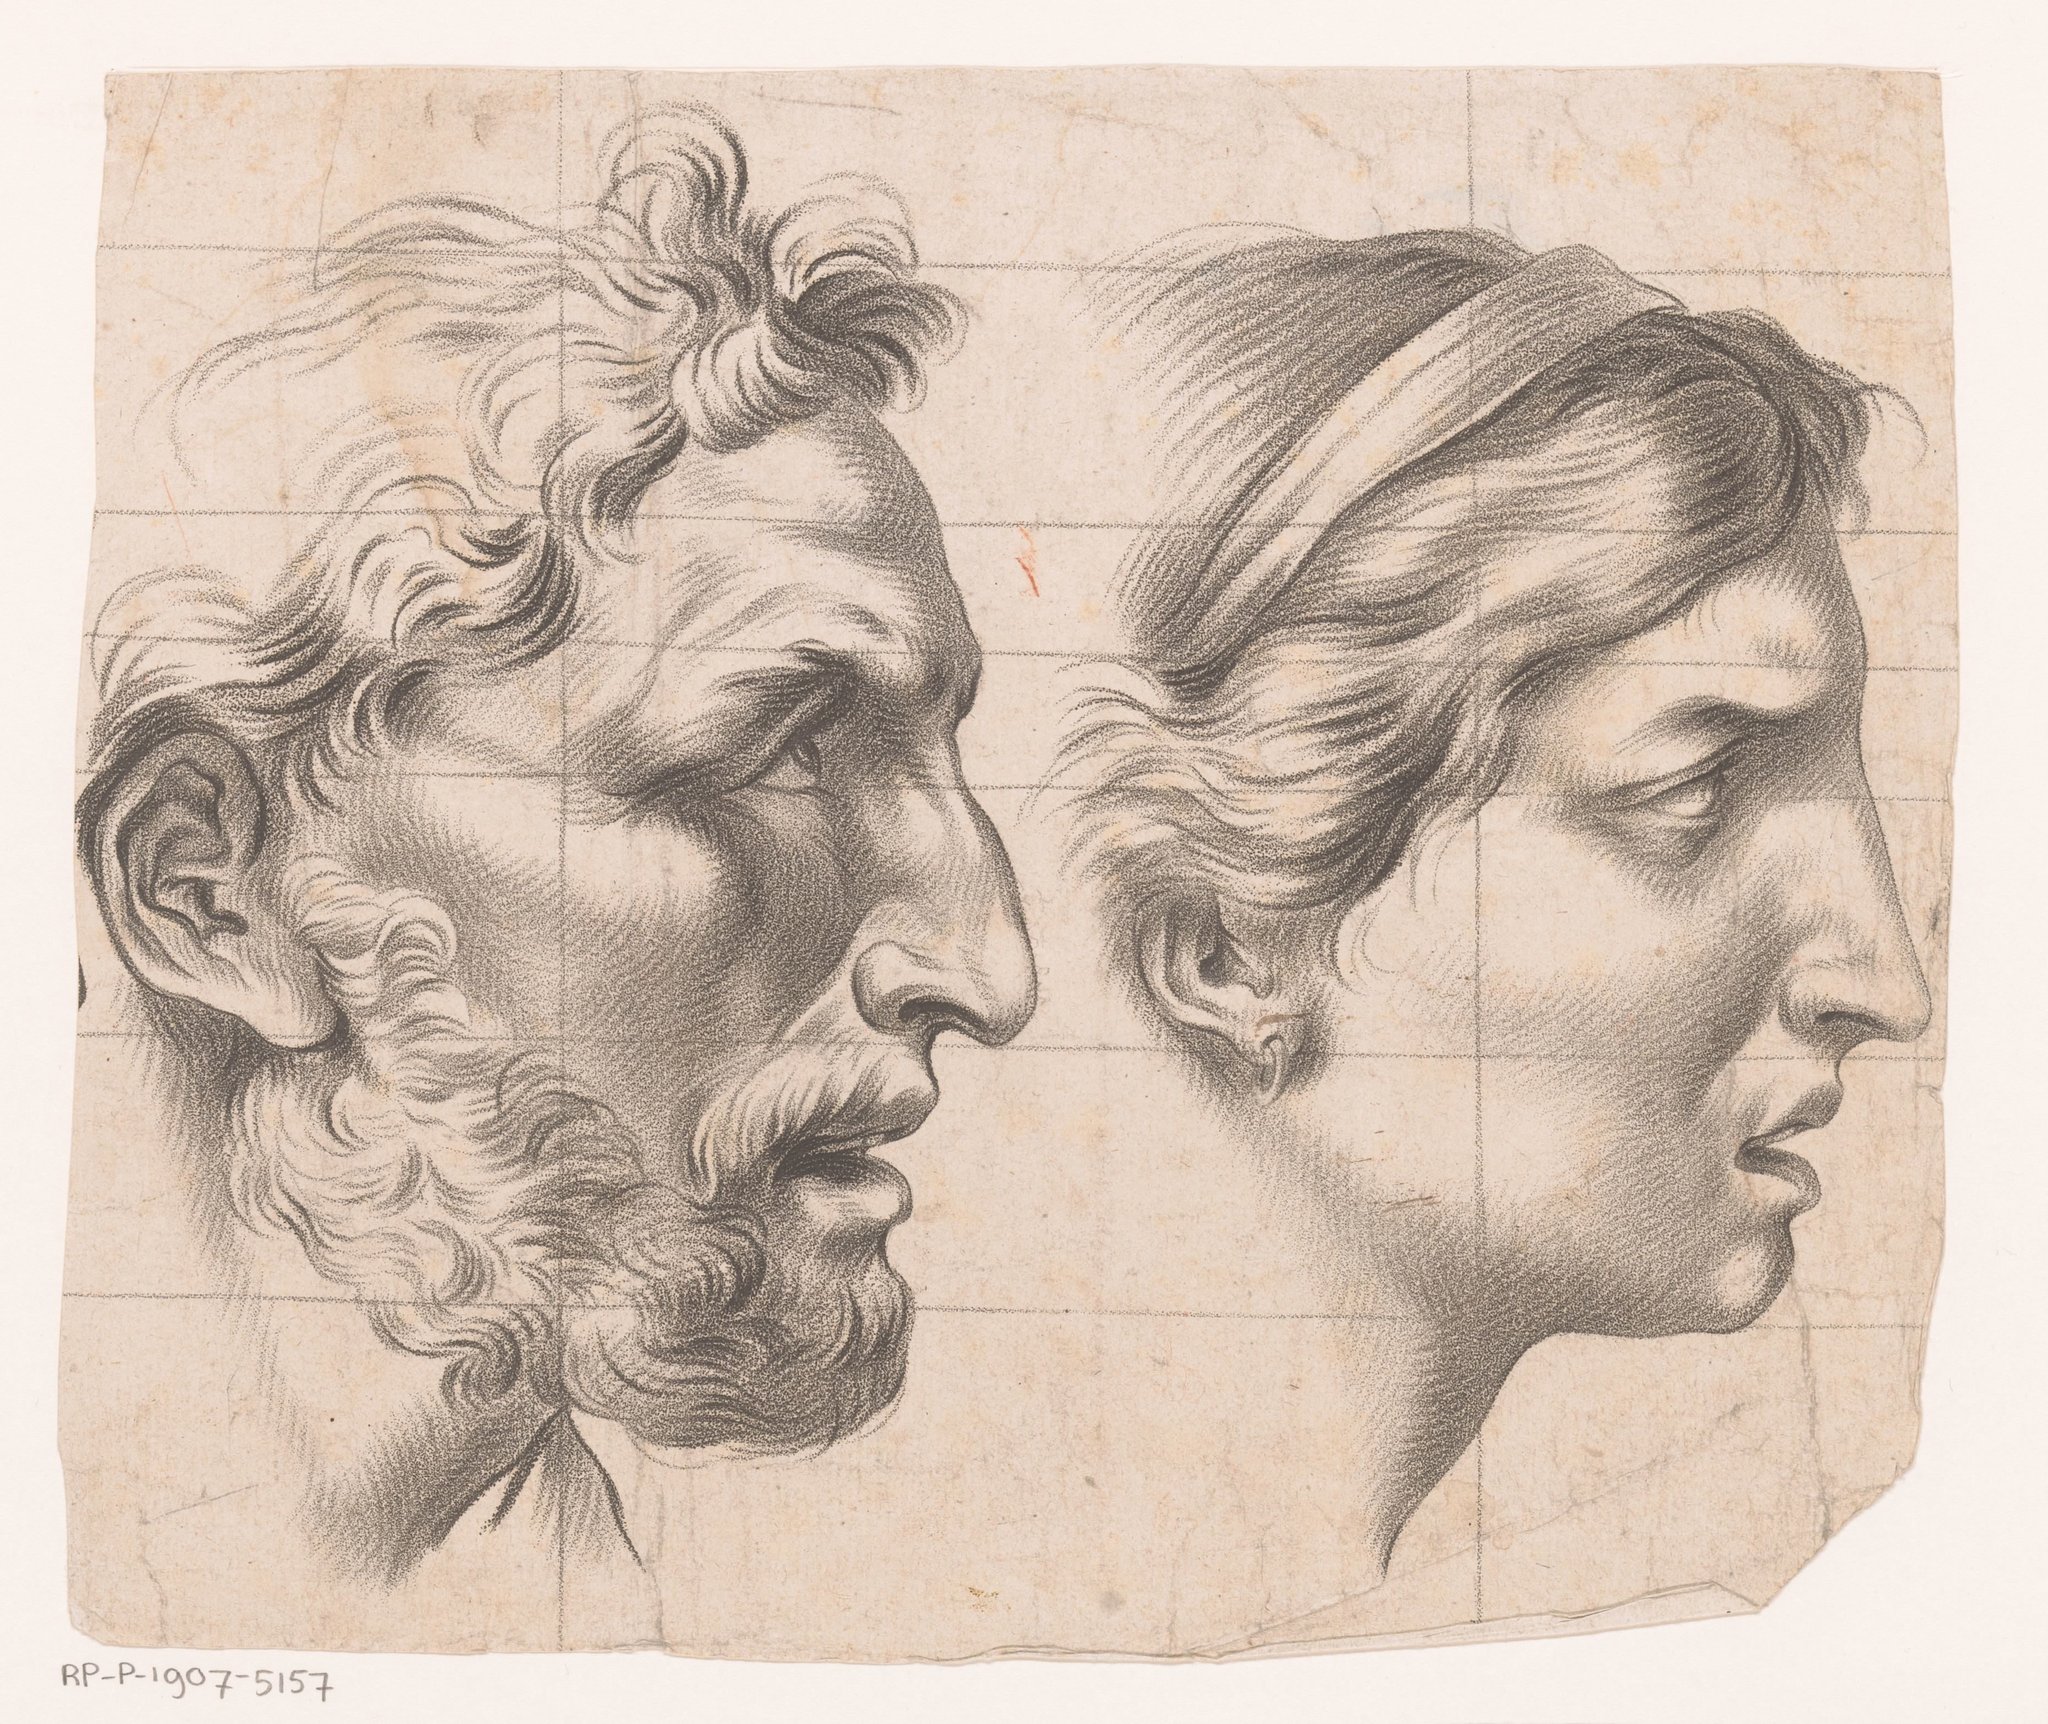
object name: print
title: Principes van het tekenen naar de natuur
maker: petit (graveur)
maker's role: print maker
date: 1784-1826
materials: paper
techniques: printmaking, etching, drawing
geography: paris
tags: drawing, sketch, head (human), head (human) - aa - female human figure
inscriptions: collector's mark: Lugt 2228